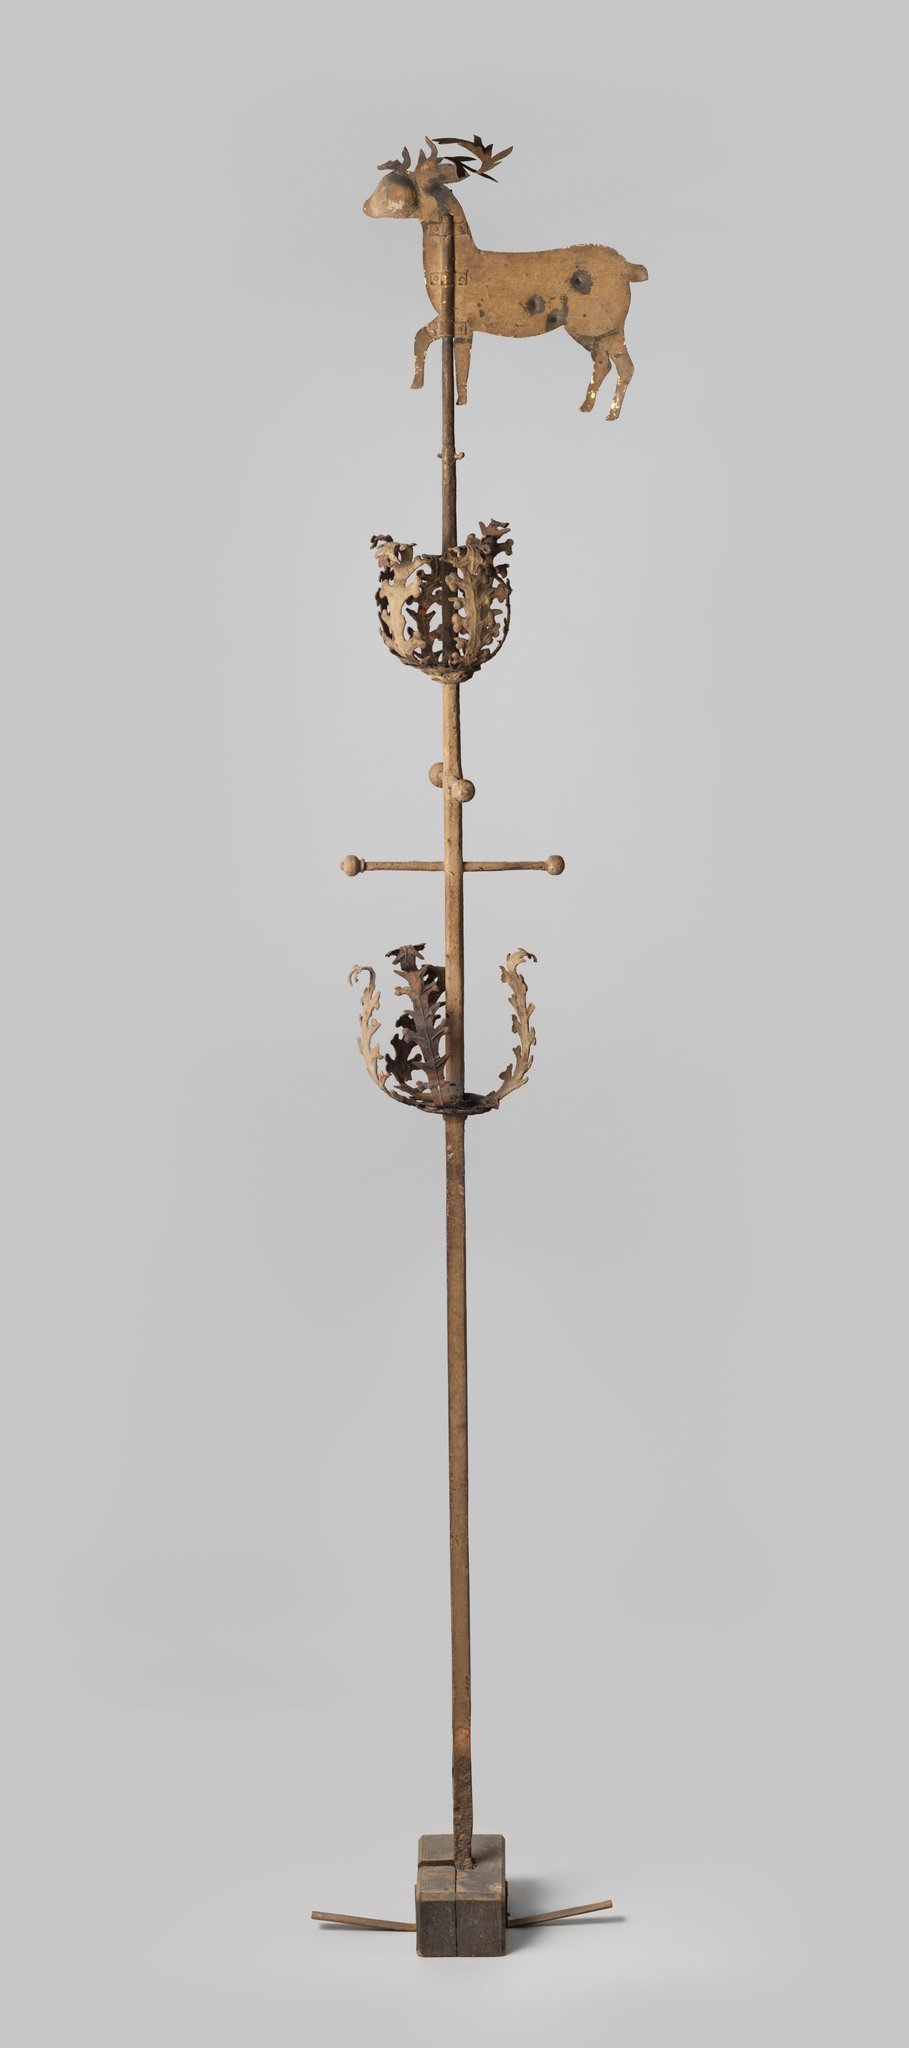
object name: weather vane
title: Windwijzer met hert als vaan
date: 1600-1699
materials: iron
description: Een ijzeren windwijzer met een hert als vaan, de stang is versierd met twee korven van gesmeed ijzeren bladeren.